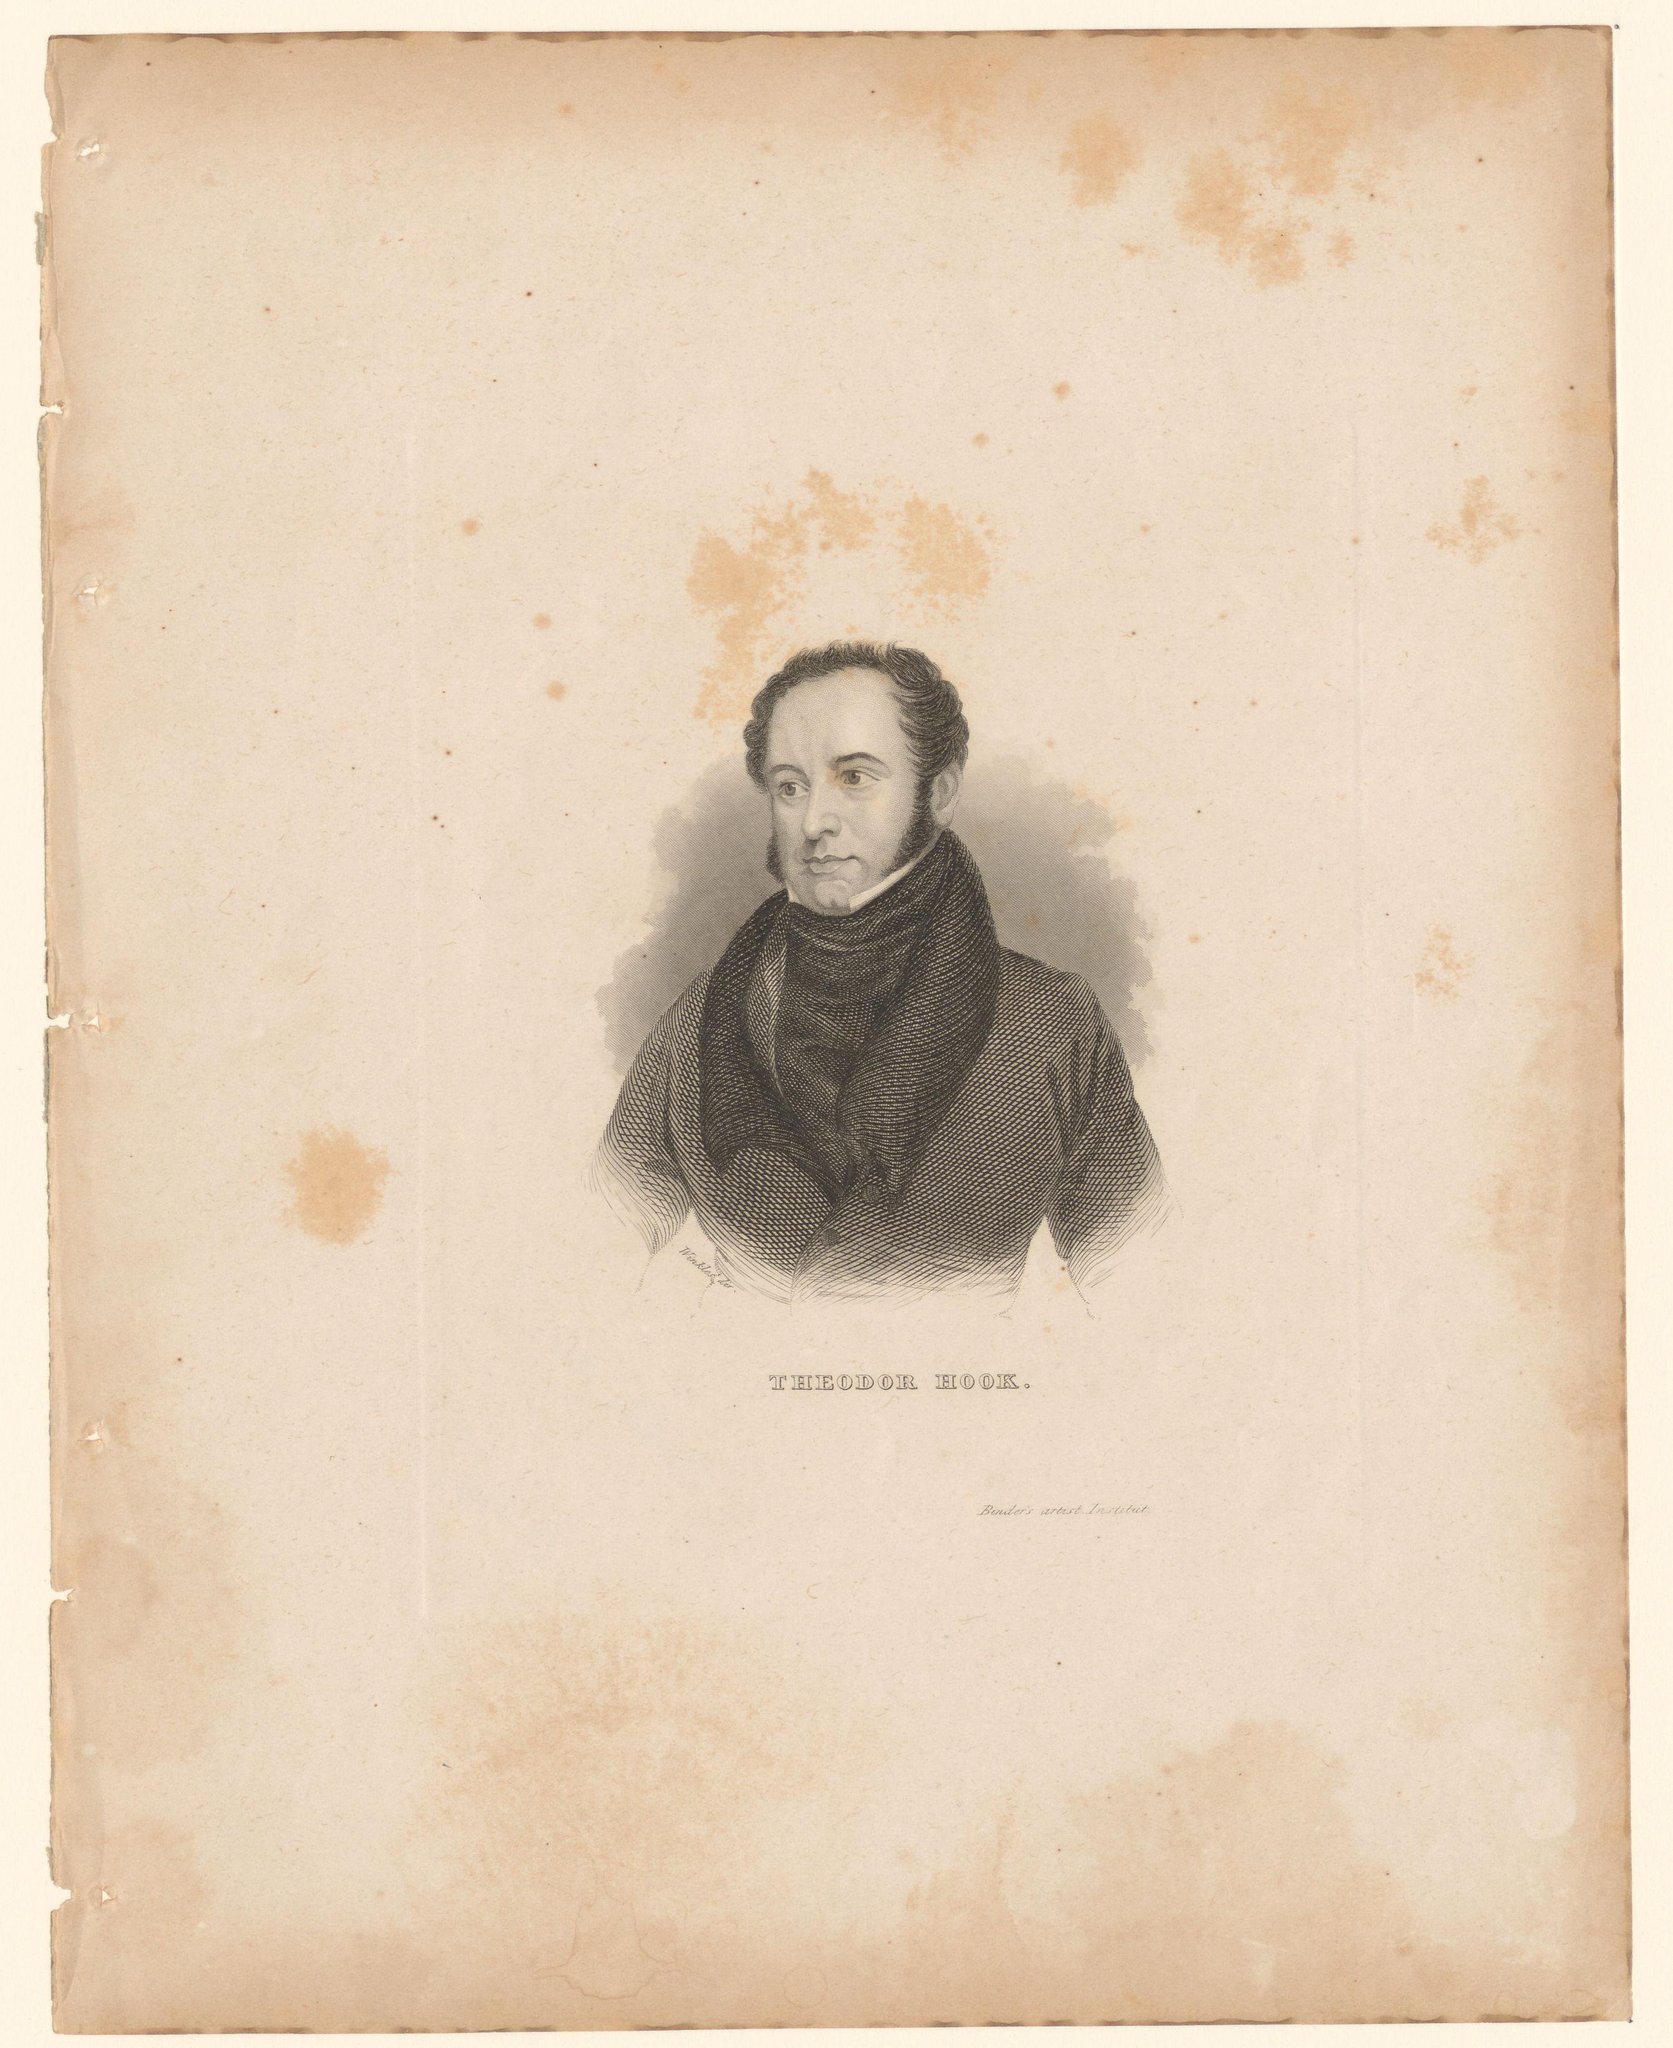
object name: print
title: Portret van Theodore Edward Hook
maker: henry winkles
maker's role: painter, print maker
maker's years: 1801-1860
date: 1824-1850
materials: paper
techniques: engraving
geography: leipzig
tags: london, historical persons, portrait, self-portrait of artist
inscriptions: collector's mark: Lugt 2228, collector's mark: Lugt 2760